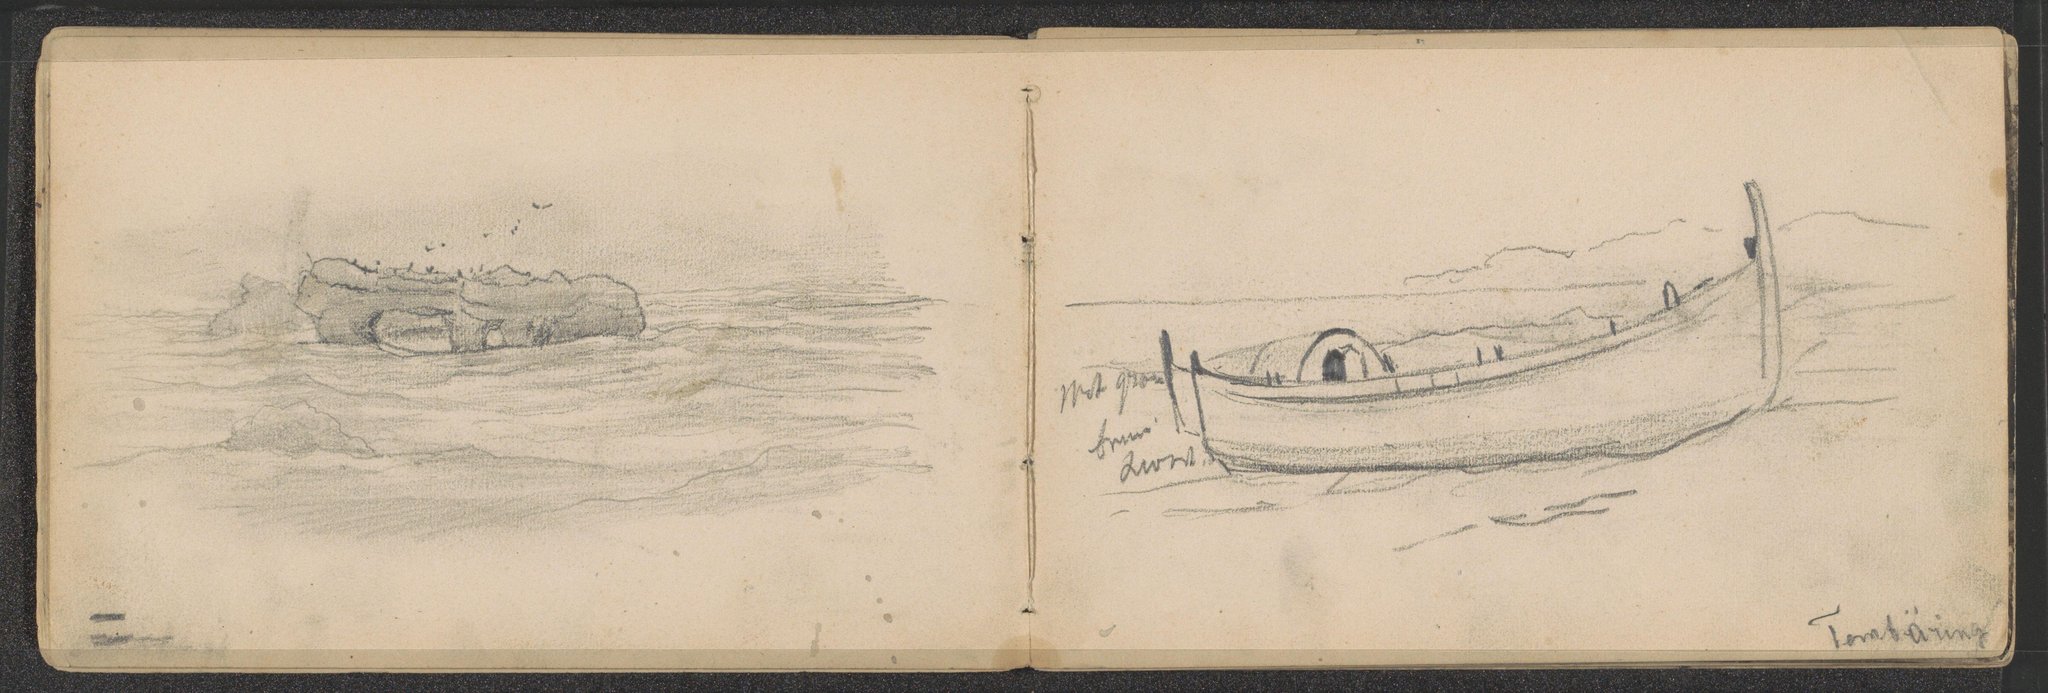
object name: sketchbook leaf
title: Boten op het land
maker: louis apol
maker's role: draughtsman, painter, print maker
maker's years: 1850-1936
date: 1880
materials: paper, pencil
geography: barentsz sea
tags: coast (in polar regions), rowing-boat, canoe, etc.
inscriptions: annotation: ‘Terntäring[?]’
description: Blad 10 recto uit een schetsboek met 35 bladen betekend tijdens de expeditie naar Nova Zembla in 1880.